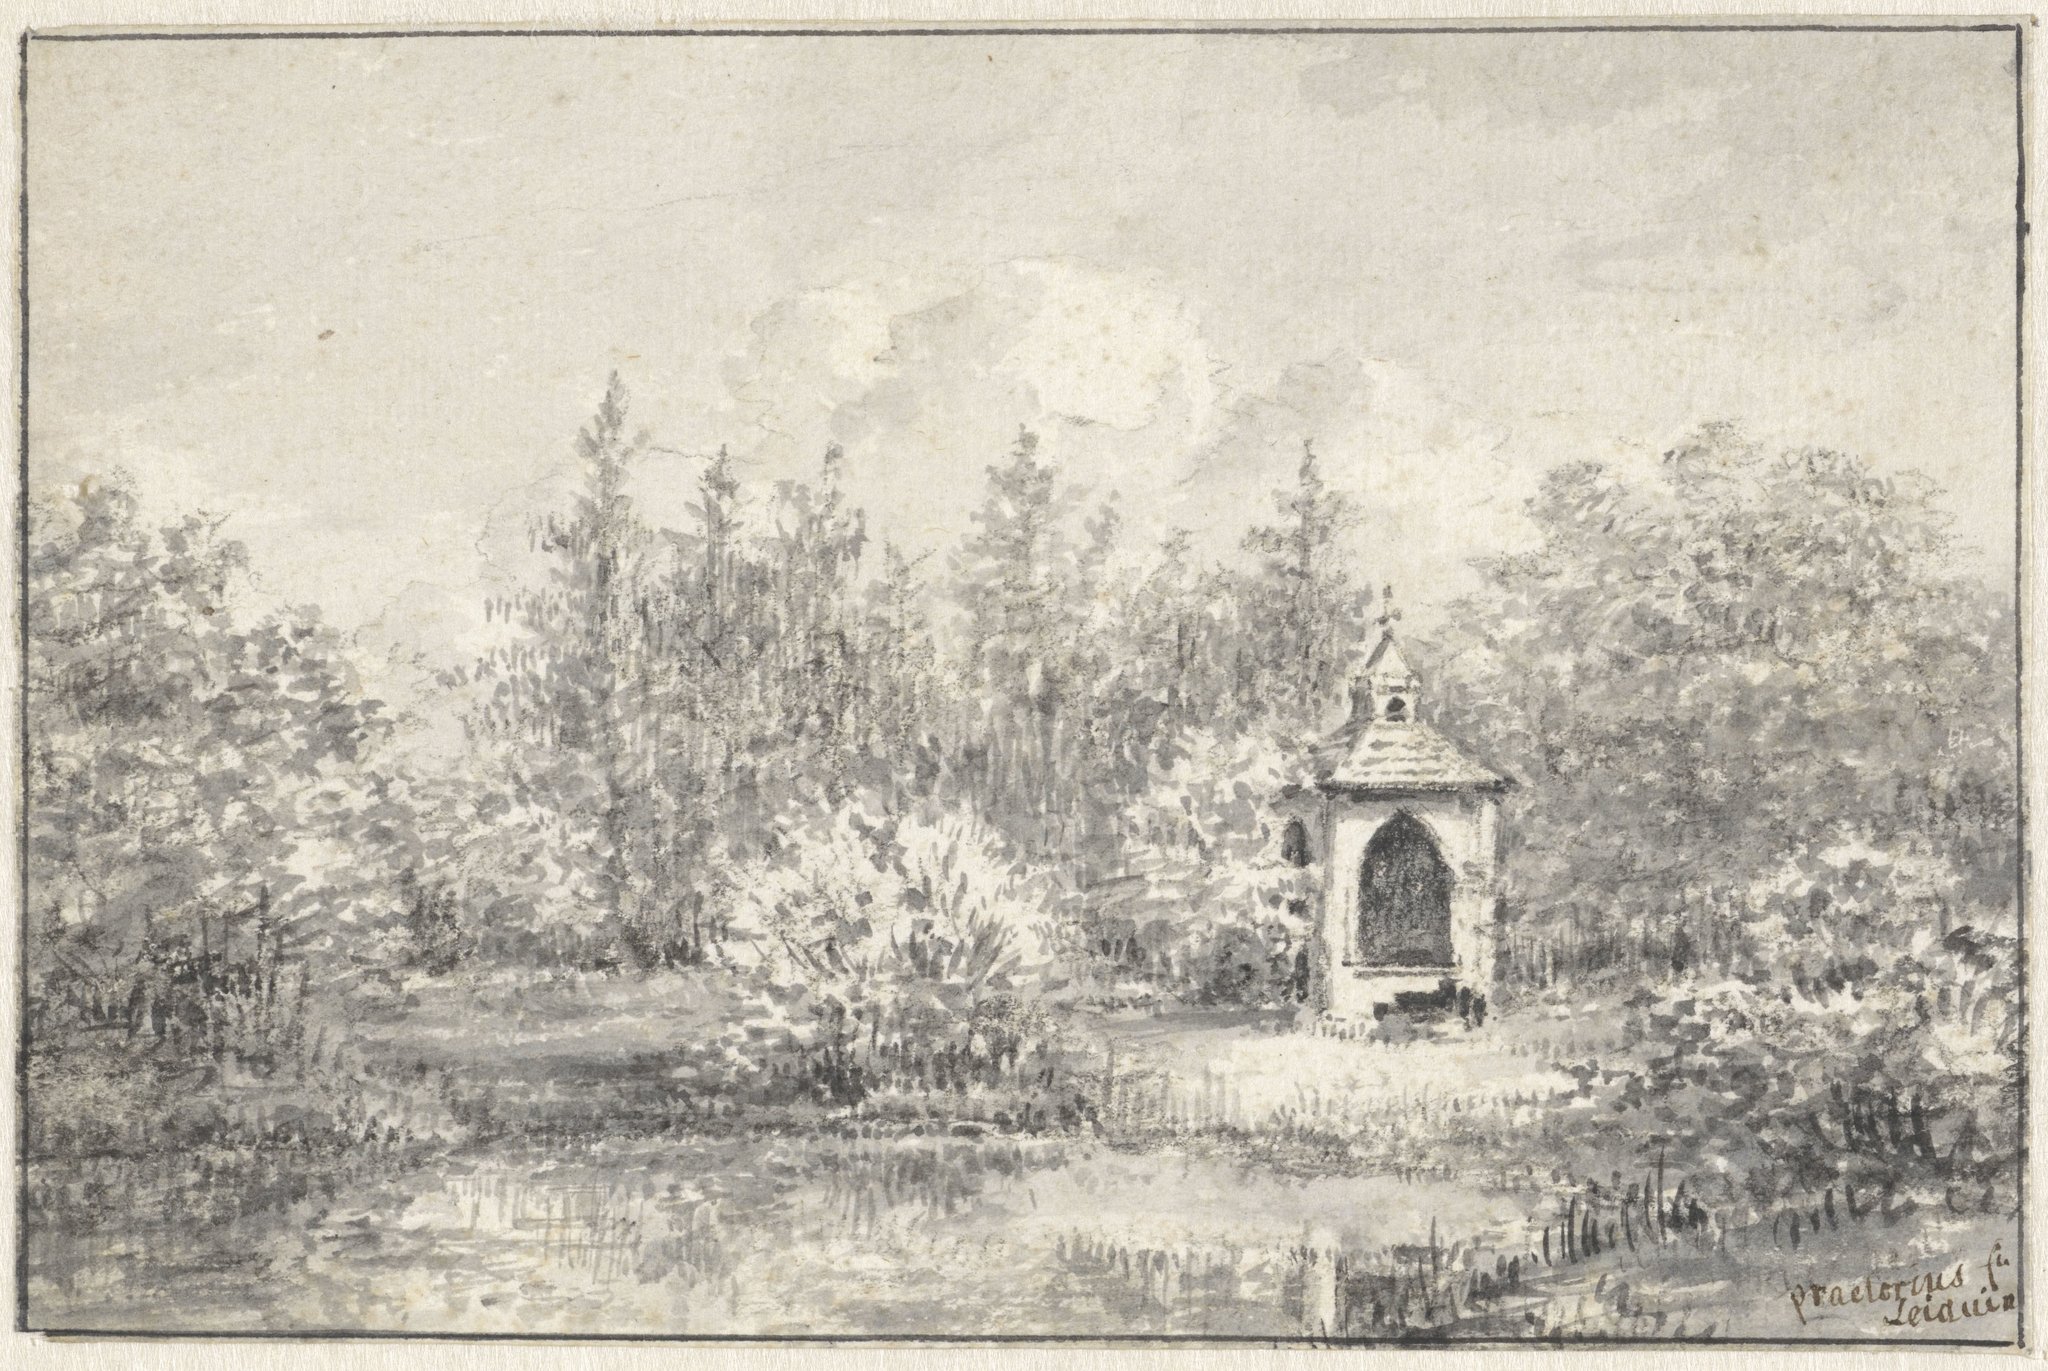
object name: drawing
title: Gezicht in het park van Leiduin, met huisje tussen de bomen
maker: pieter ernst hendrik praetorius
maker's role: draughtsman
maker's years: 1791-1876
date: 1801-1876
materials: chalk, paper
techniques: brush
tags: public gardens, park